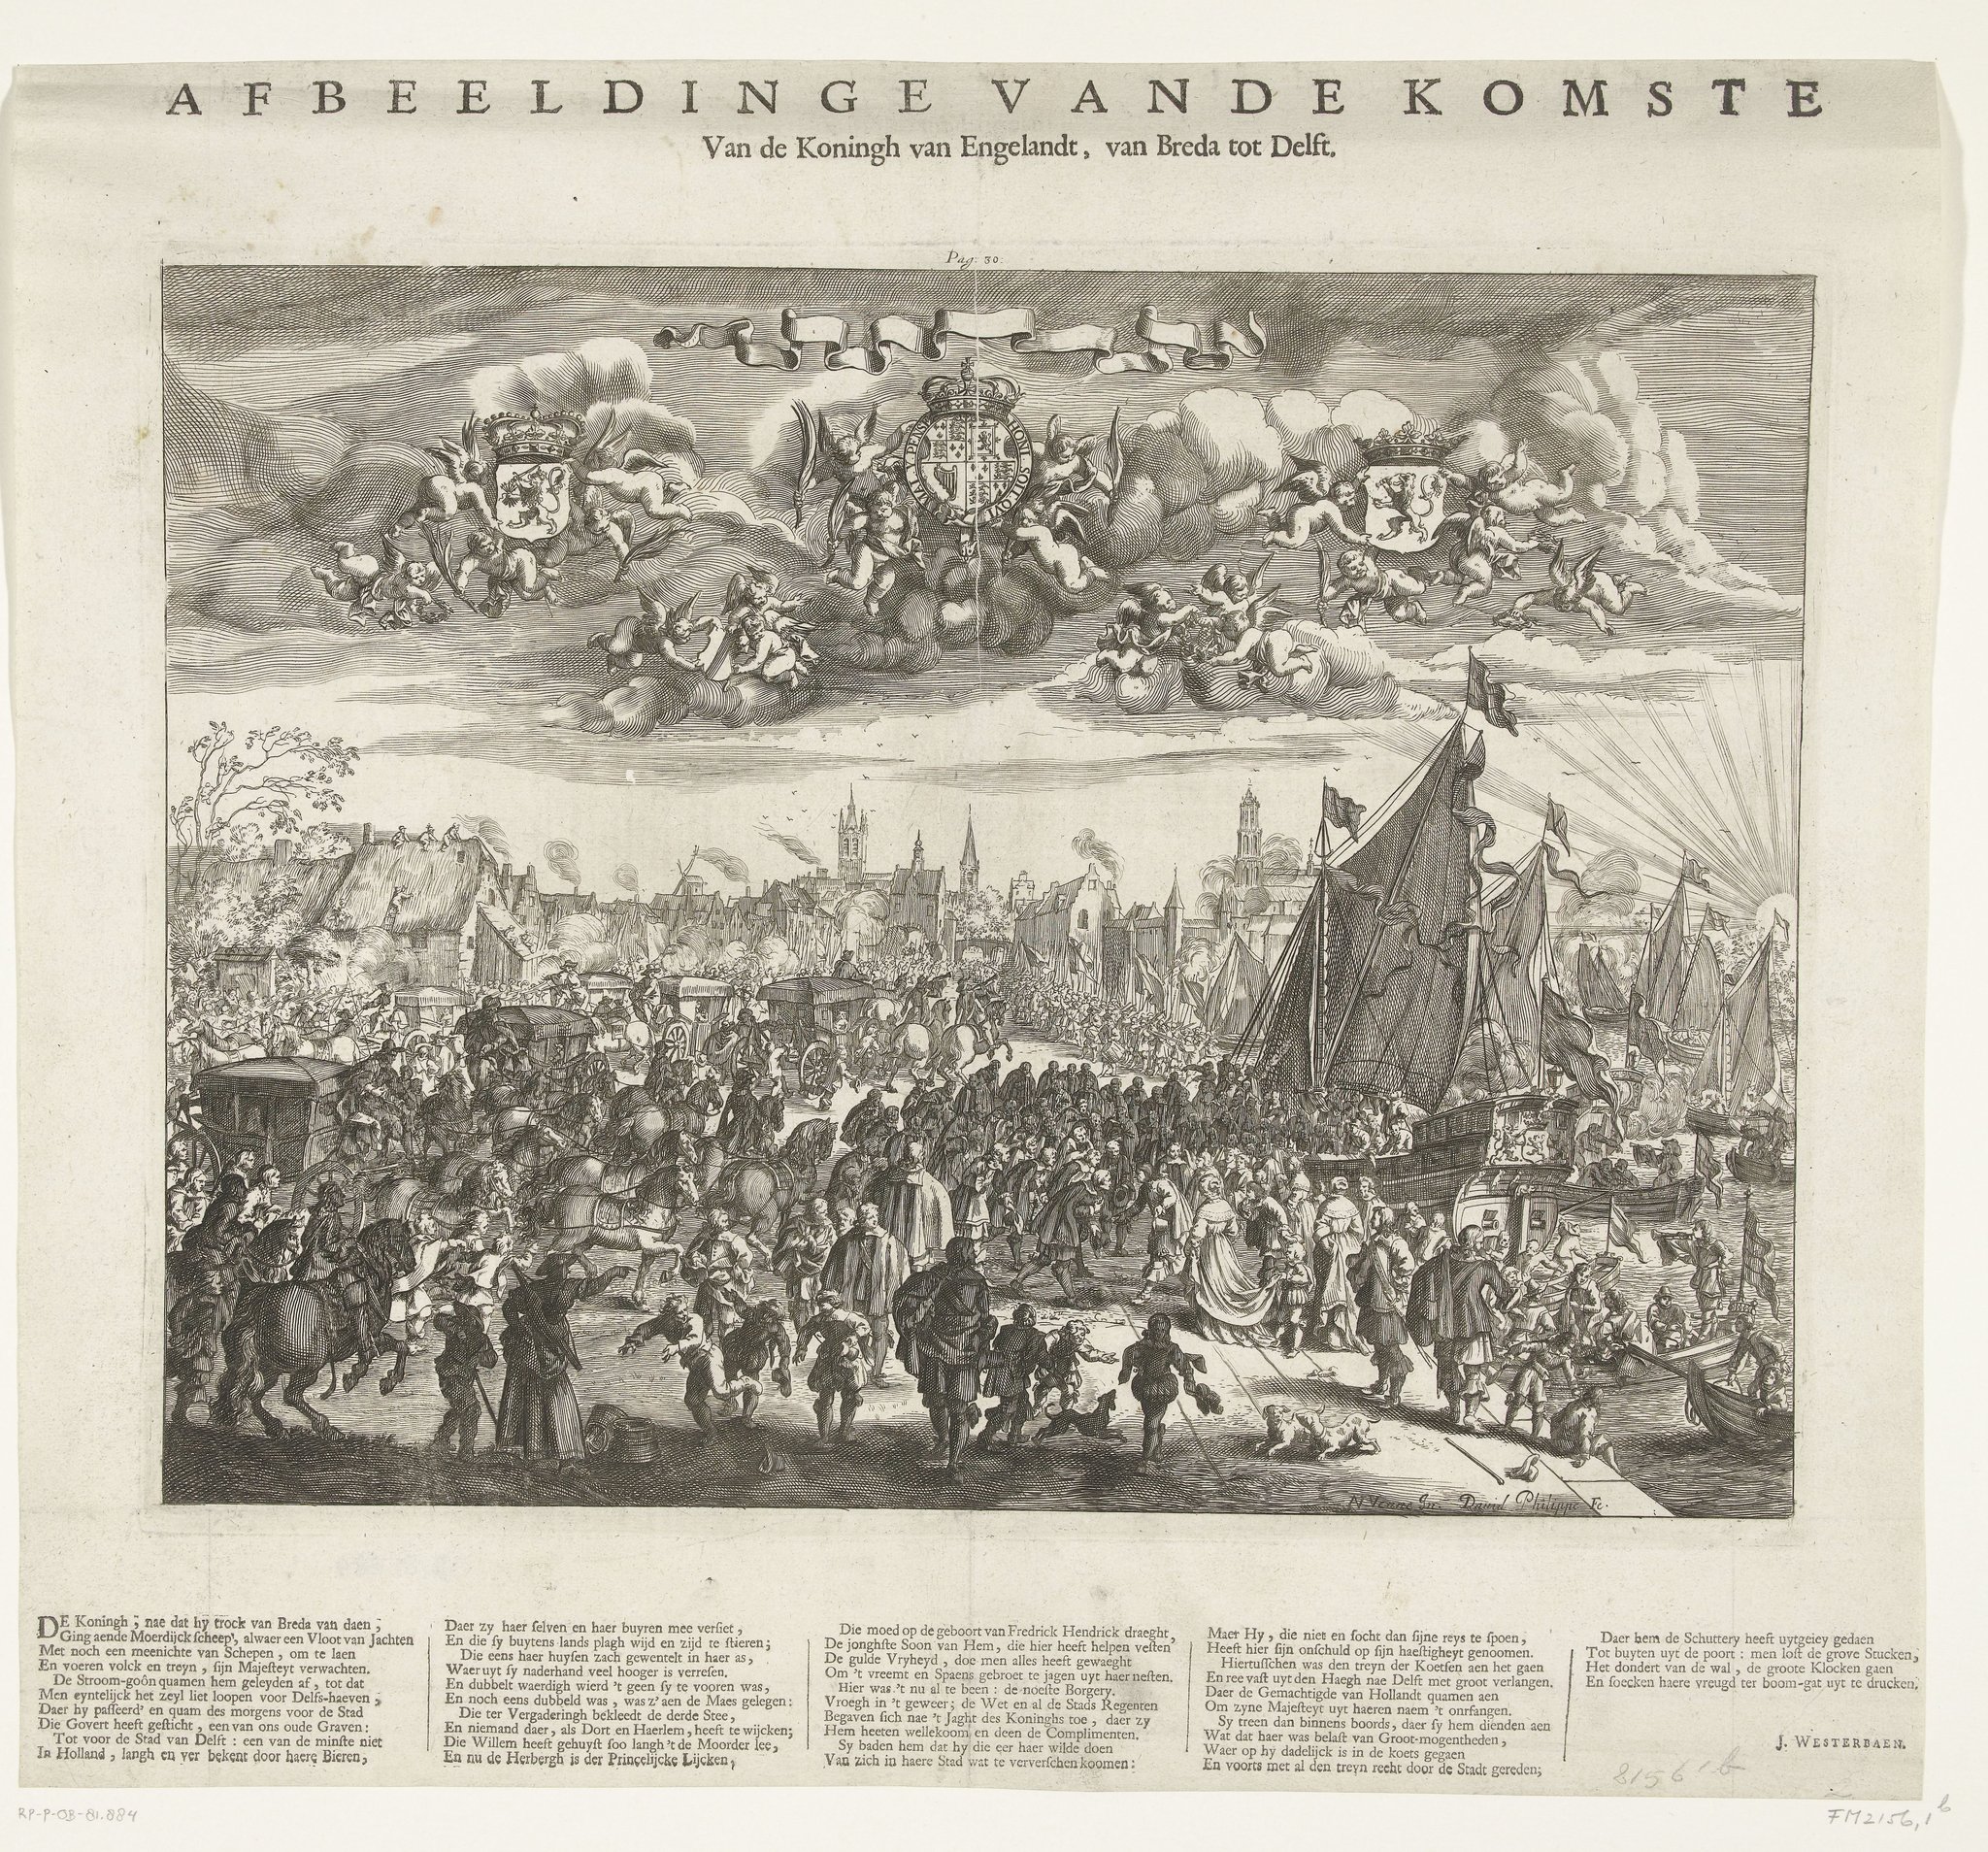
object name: print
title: Afbeeldinge van de Komste Van de Koningh van Engelandt, van Breda tot delft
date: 1660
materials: paper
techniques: engraving, etching, letterpress printing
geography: northern netherlands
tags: london, karel ii (koning van engeland), triumphal entry and public reception, pageant, 'entrée solennelle', 'joyeuse entrée', delft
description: Aankomst van de Engelse koning Karel II vanuit Breda te Delft, 25 mei 1660. Episode tijdens zijn rondreis door en vertrek uit de Nederlanden. Een groot gezelschap verwelkomt op de kade de koning die met een boot in Delft is aangekomen. In de lucht putti met de wapens van de Republiek, de Engelse koning en Holland. Met een banderol zonder tekst. Gemerkt bovenaan: Pag. 30. Op het blad onder de plaat is een vers in 5 kolommen gedrukt.